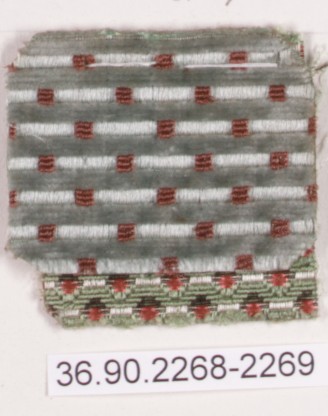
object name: piece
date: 1801-1900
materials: silk